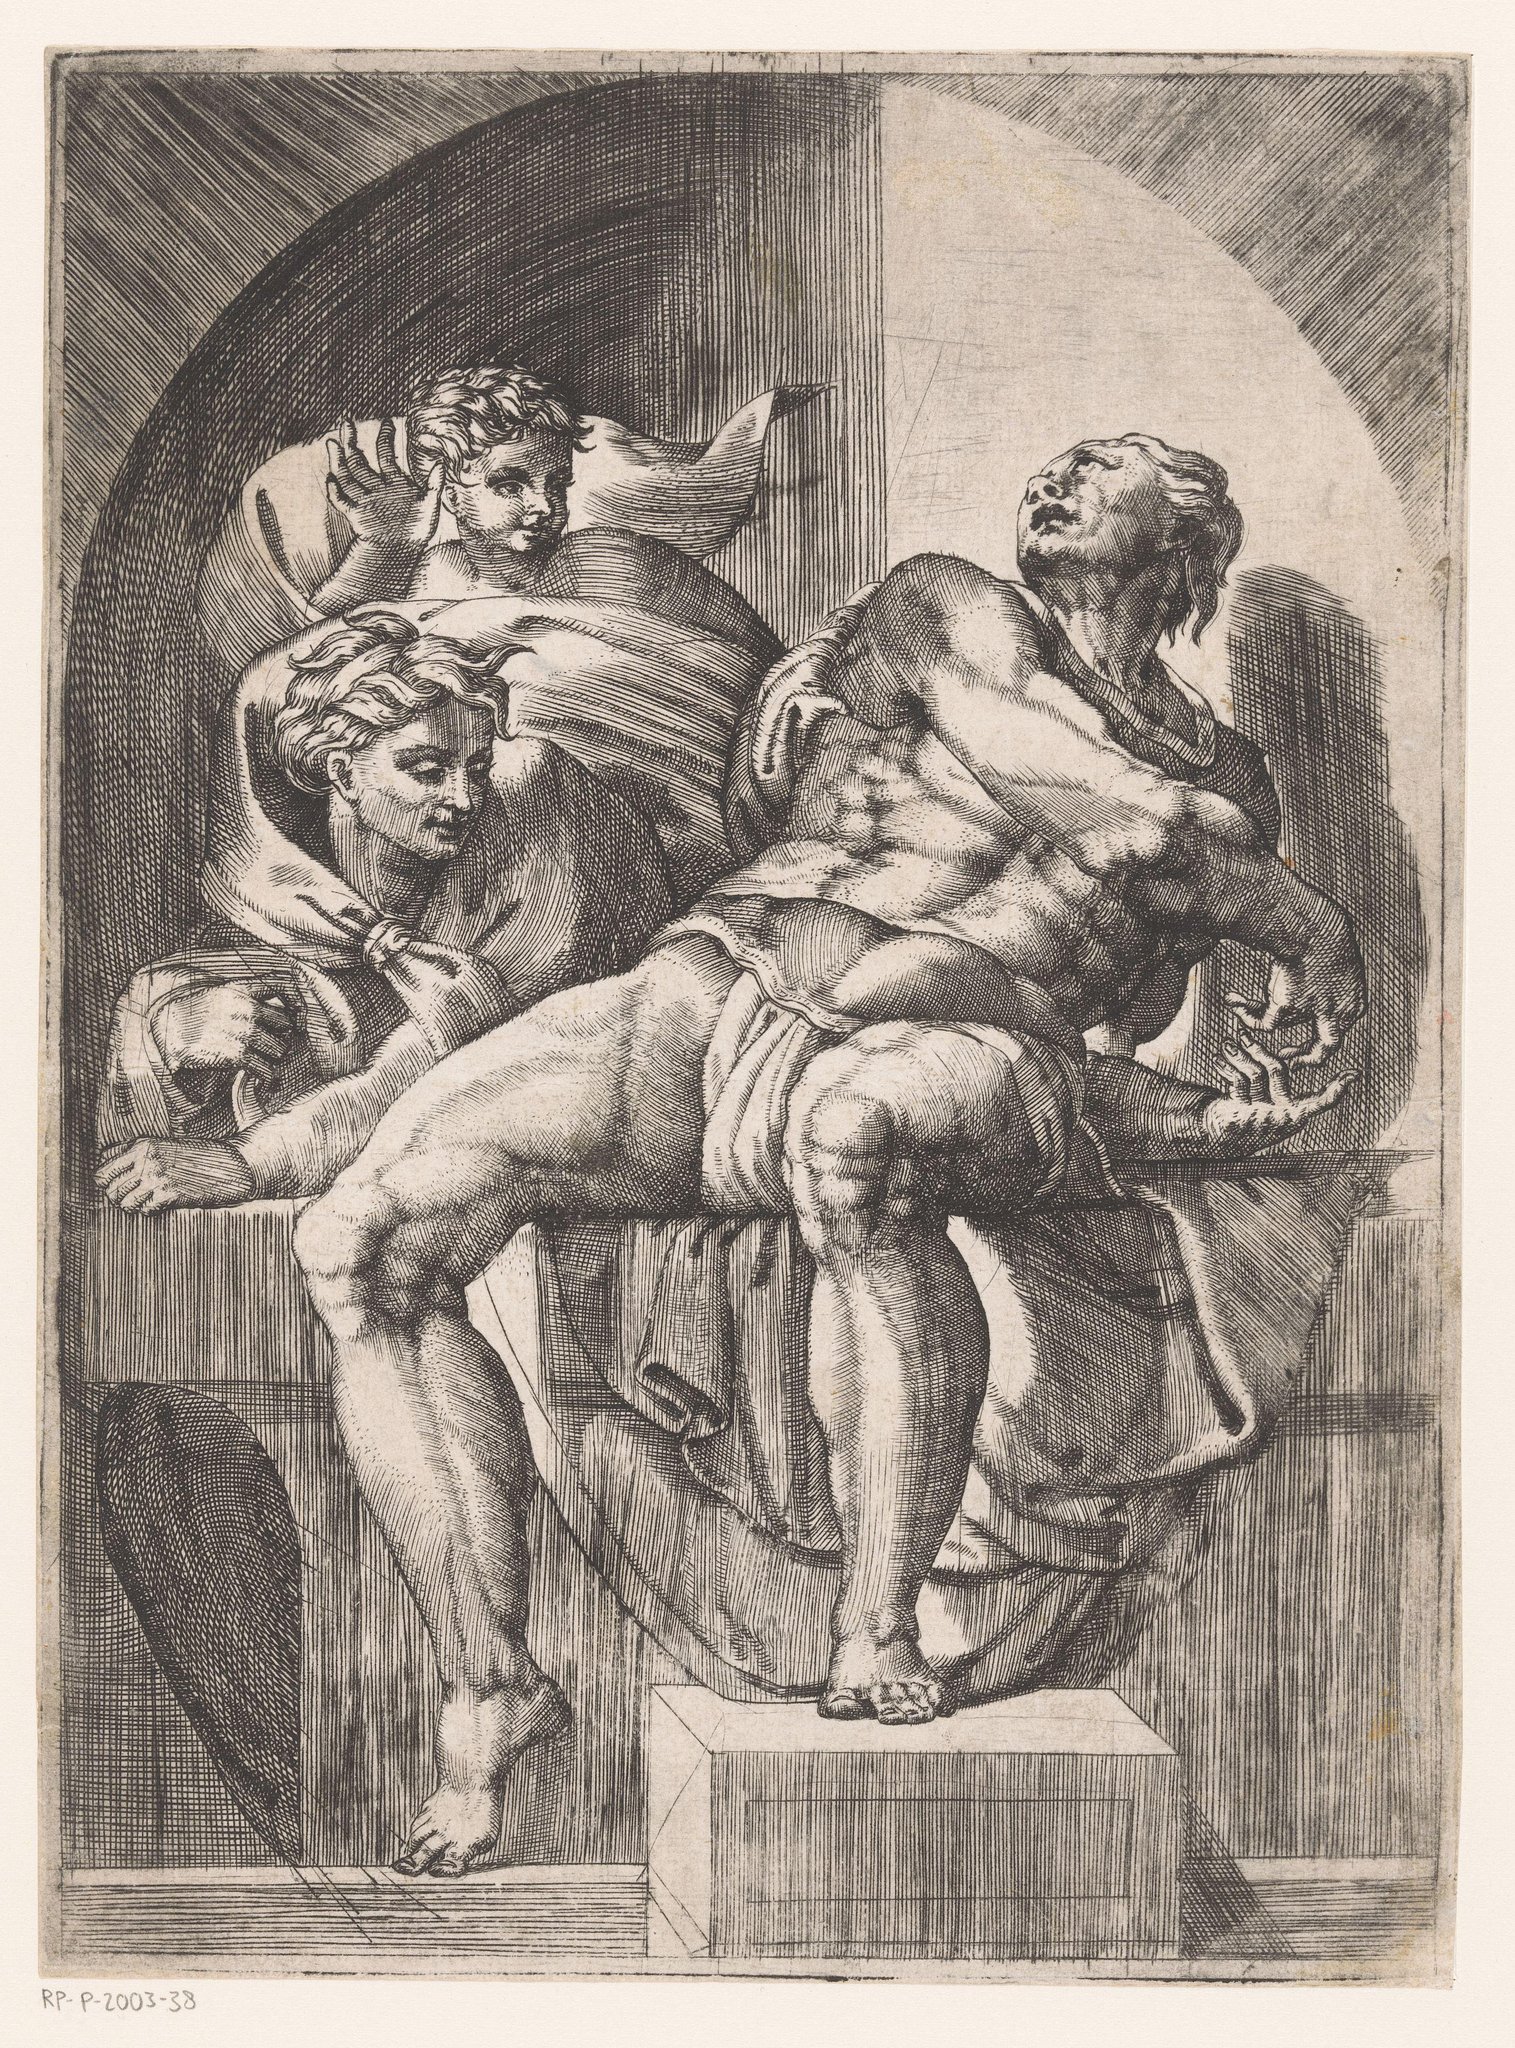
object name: print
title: Profeet Jona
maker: Anonymous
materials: paper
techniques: engraving, etching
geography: italy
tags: the twelve minor prophets (not in biblical context): hosea, joel, amos, obadiah, jonah, micah, nahum, habakkuk, zephaniah, haggai, zechariah, malachi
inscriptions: collector's mark: Lugt 2228, collector's mark: Lugt 2760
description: Prent vrij naar één van de profeten van Michelangelo's plafondschildering in de Sixtijnse Kapel in het Vaticaan.